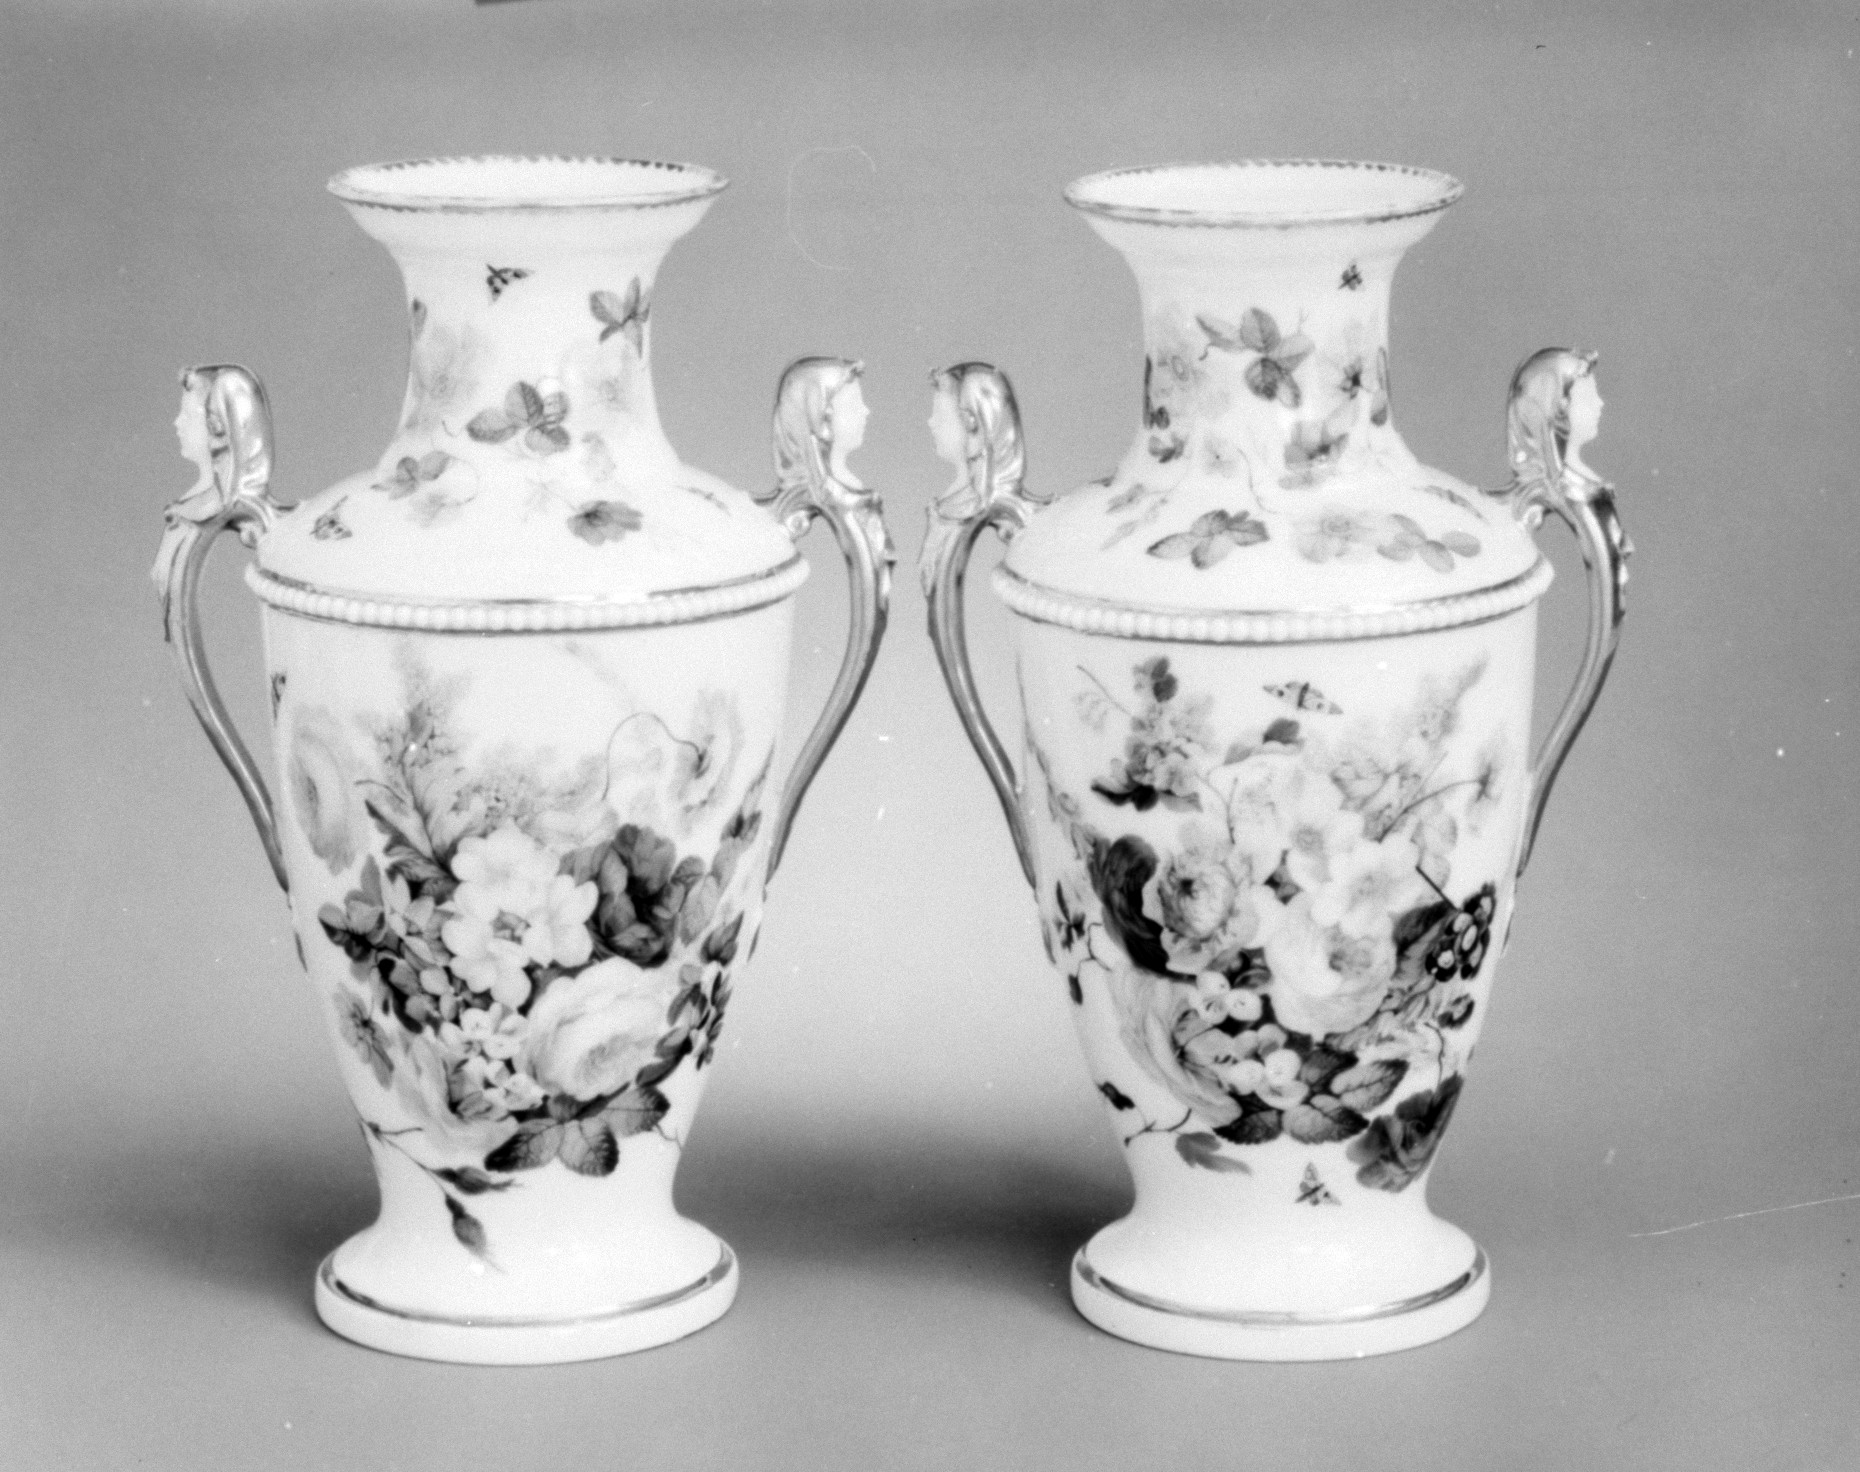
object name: vase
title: Pair of vases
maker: la courtille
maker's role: factory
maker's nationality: french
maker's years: 1771-1840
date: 1800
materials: hard paste porcelain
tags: flowers